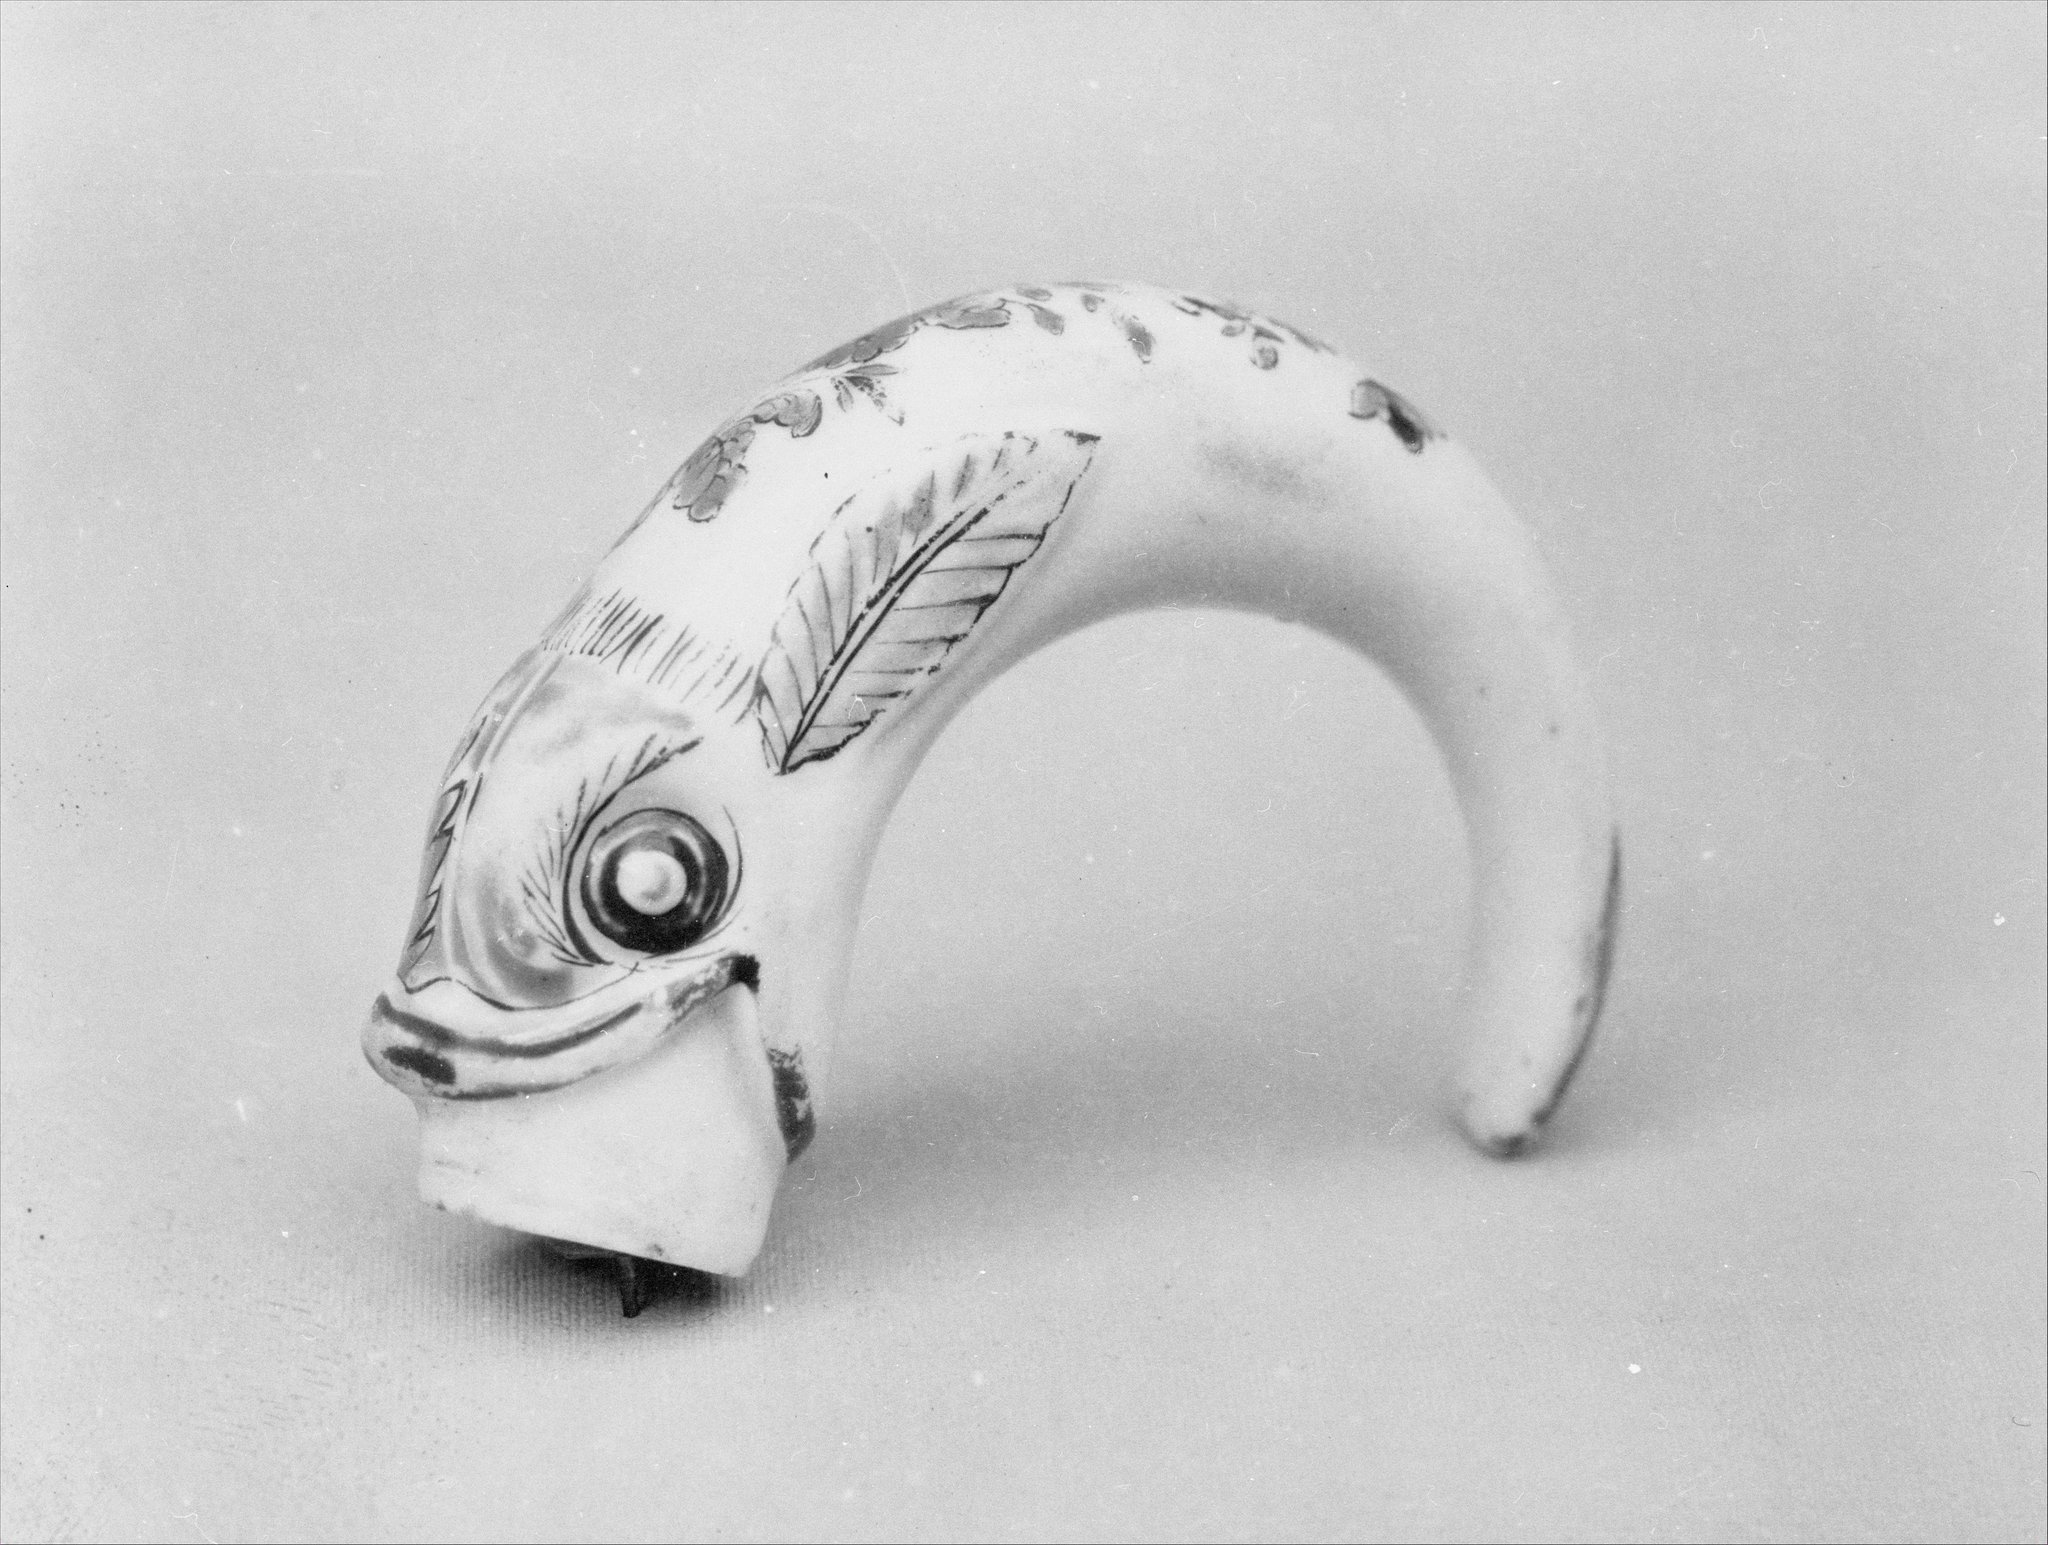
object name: cane handle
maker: saint-cloud factory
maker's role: factory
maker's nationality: french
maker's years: 1693-1766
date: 1735-1745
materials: soft paste porcelain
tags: fish